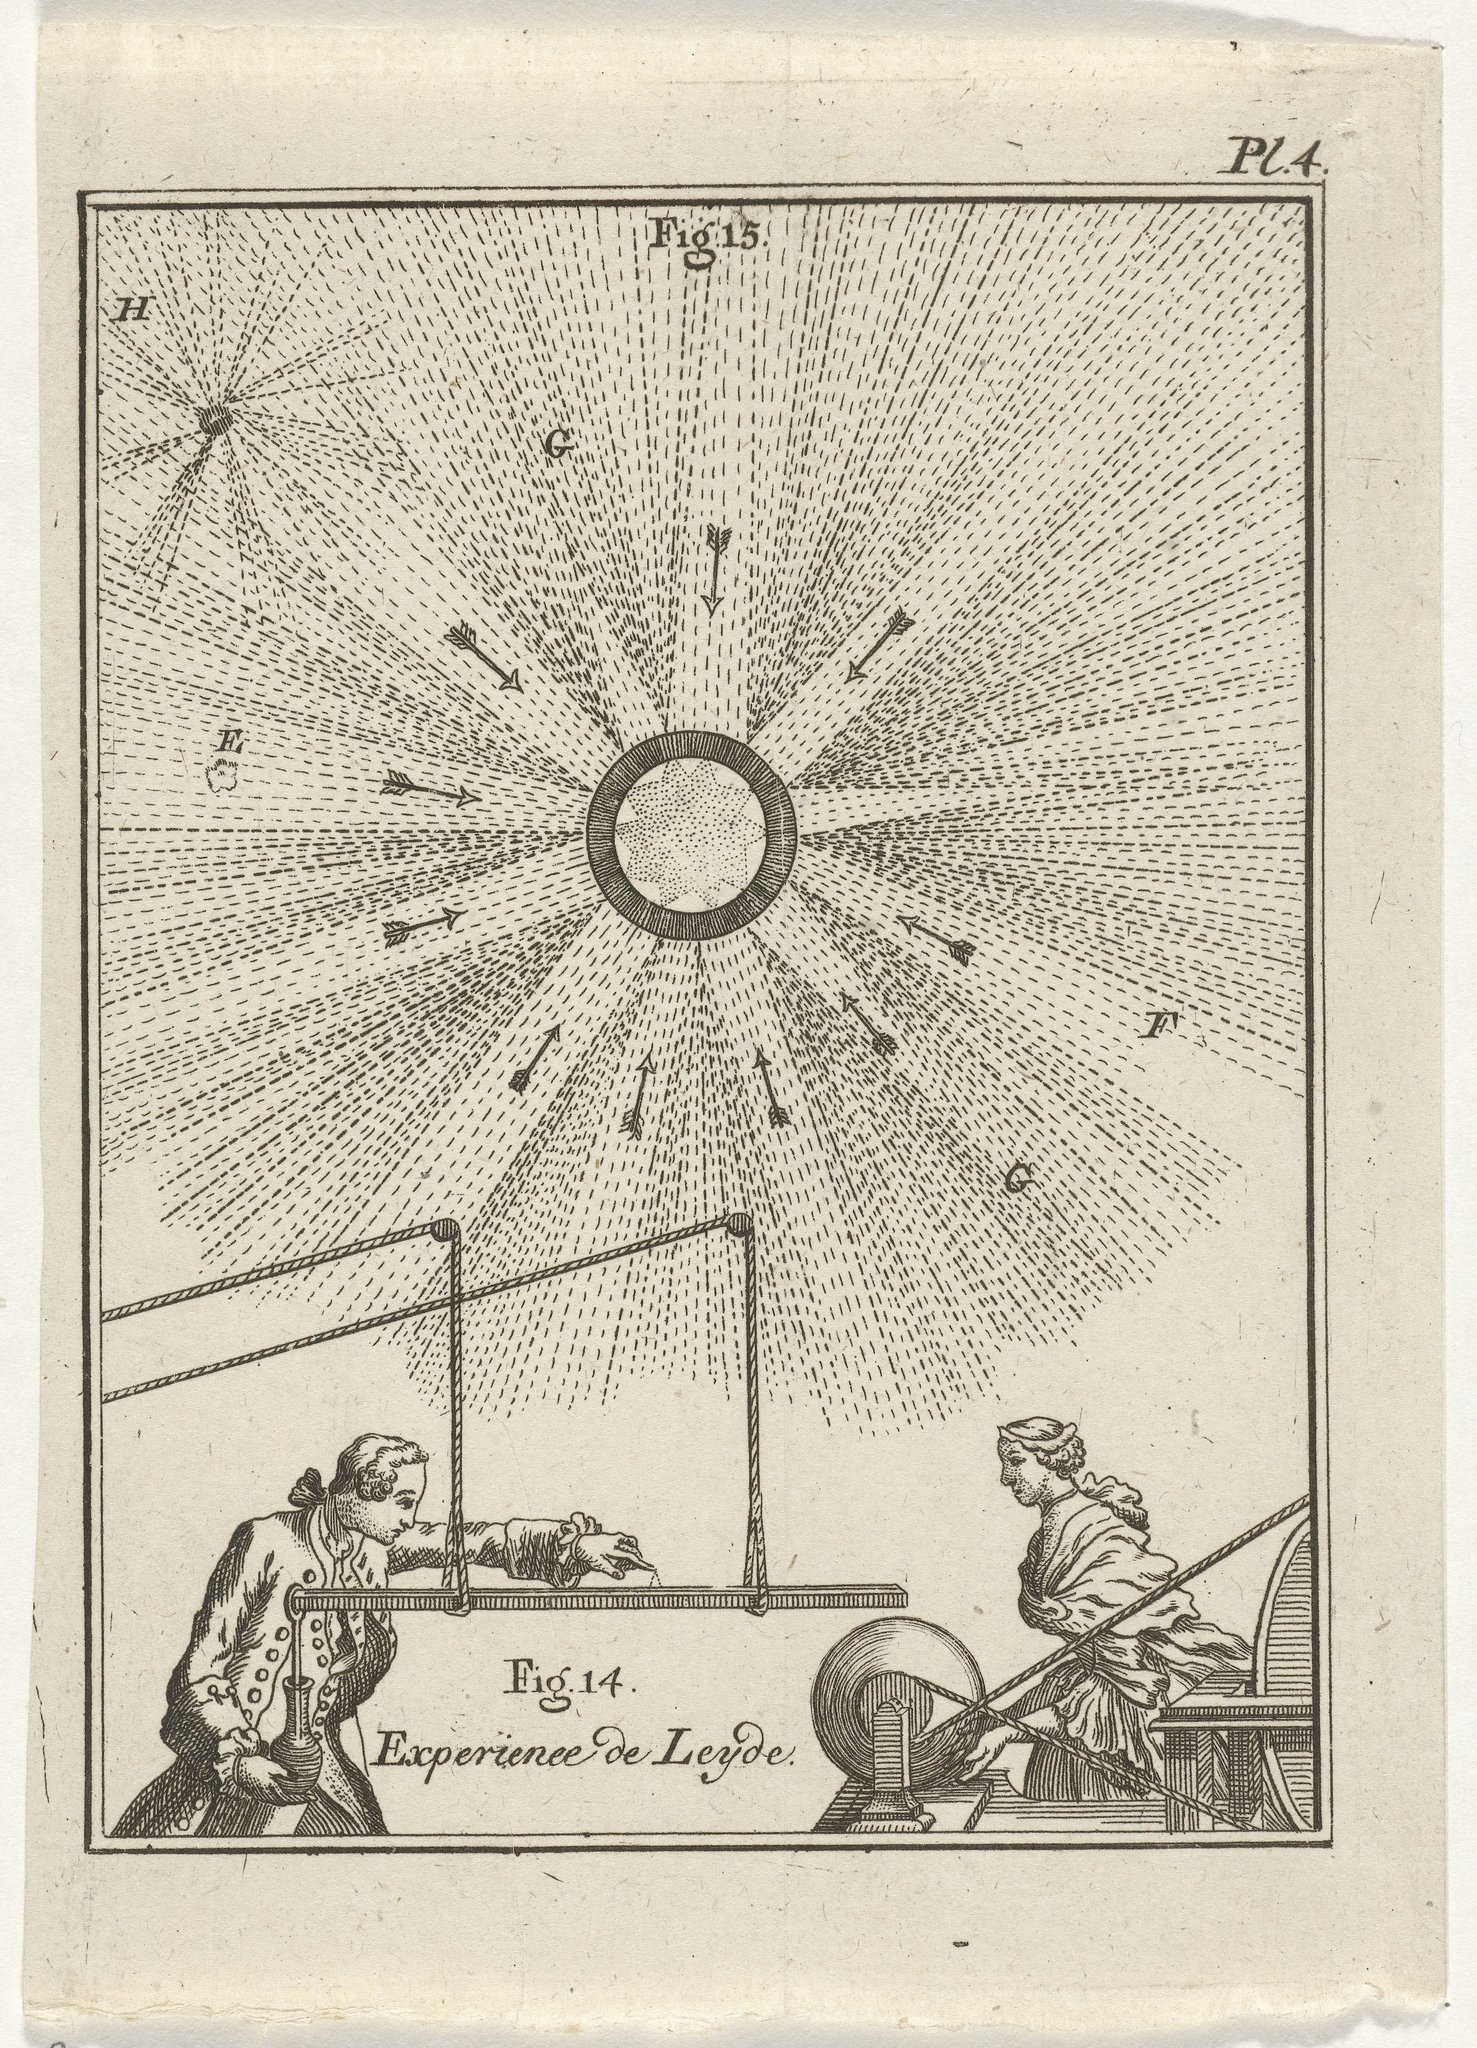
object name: print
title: Natuurkundig experiment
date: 1759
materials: paper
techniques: etching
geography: amsterdam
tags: physics (+ tools, instruments; laboratory equipment ~ scientific research)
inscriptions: collector's mark: Lugt 2228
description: Illustratie voor: Nollet, Jean Antoine. Natuurkundige lessen, door proefneemingen bevestigd, eerste deel. Amsterdam: Kornelis van Tongerlo, 1759.